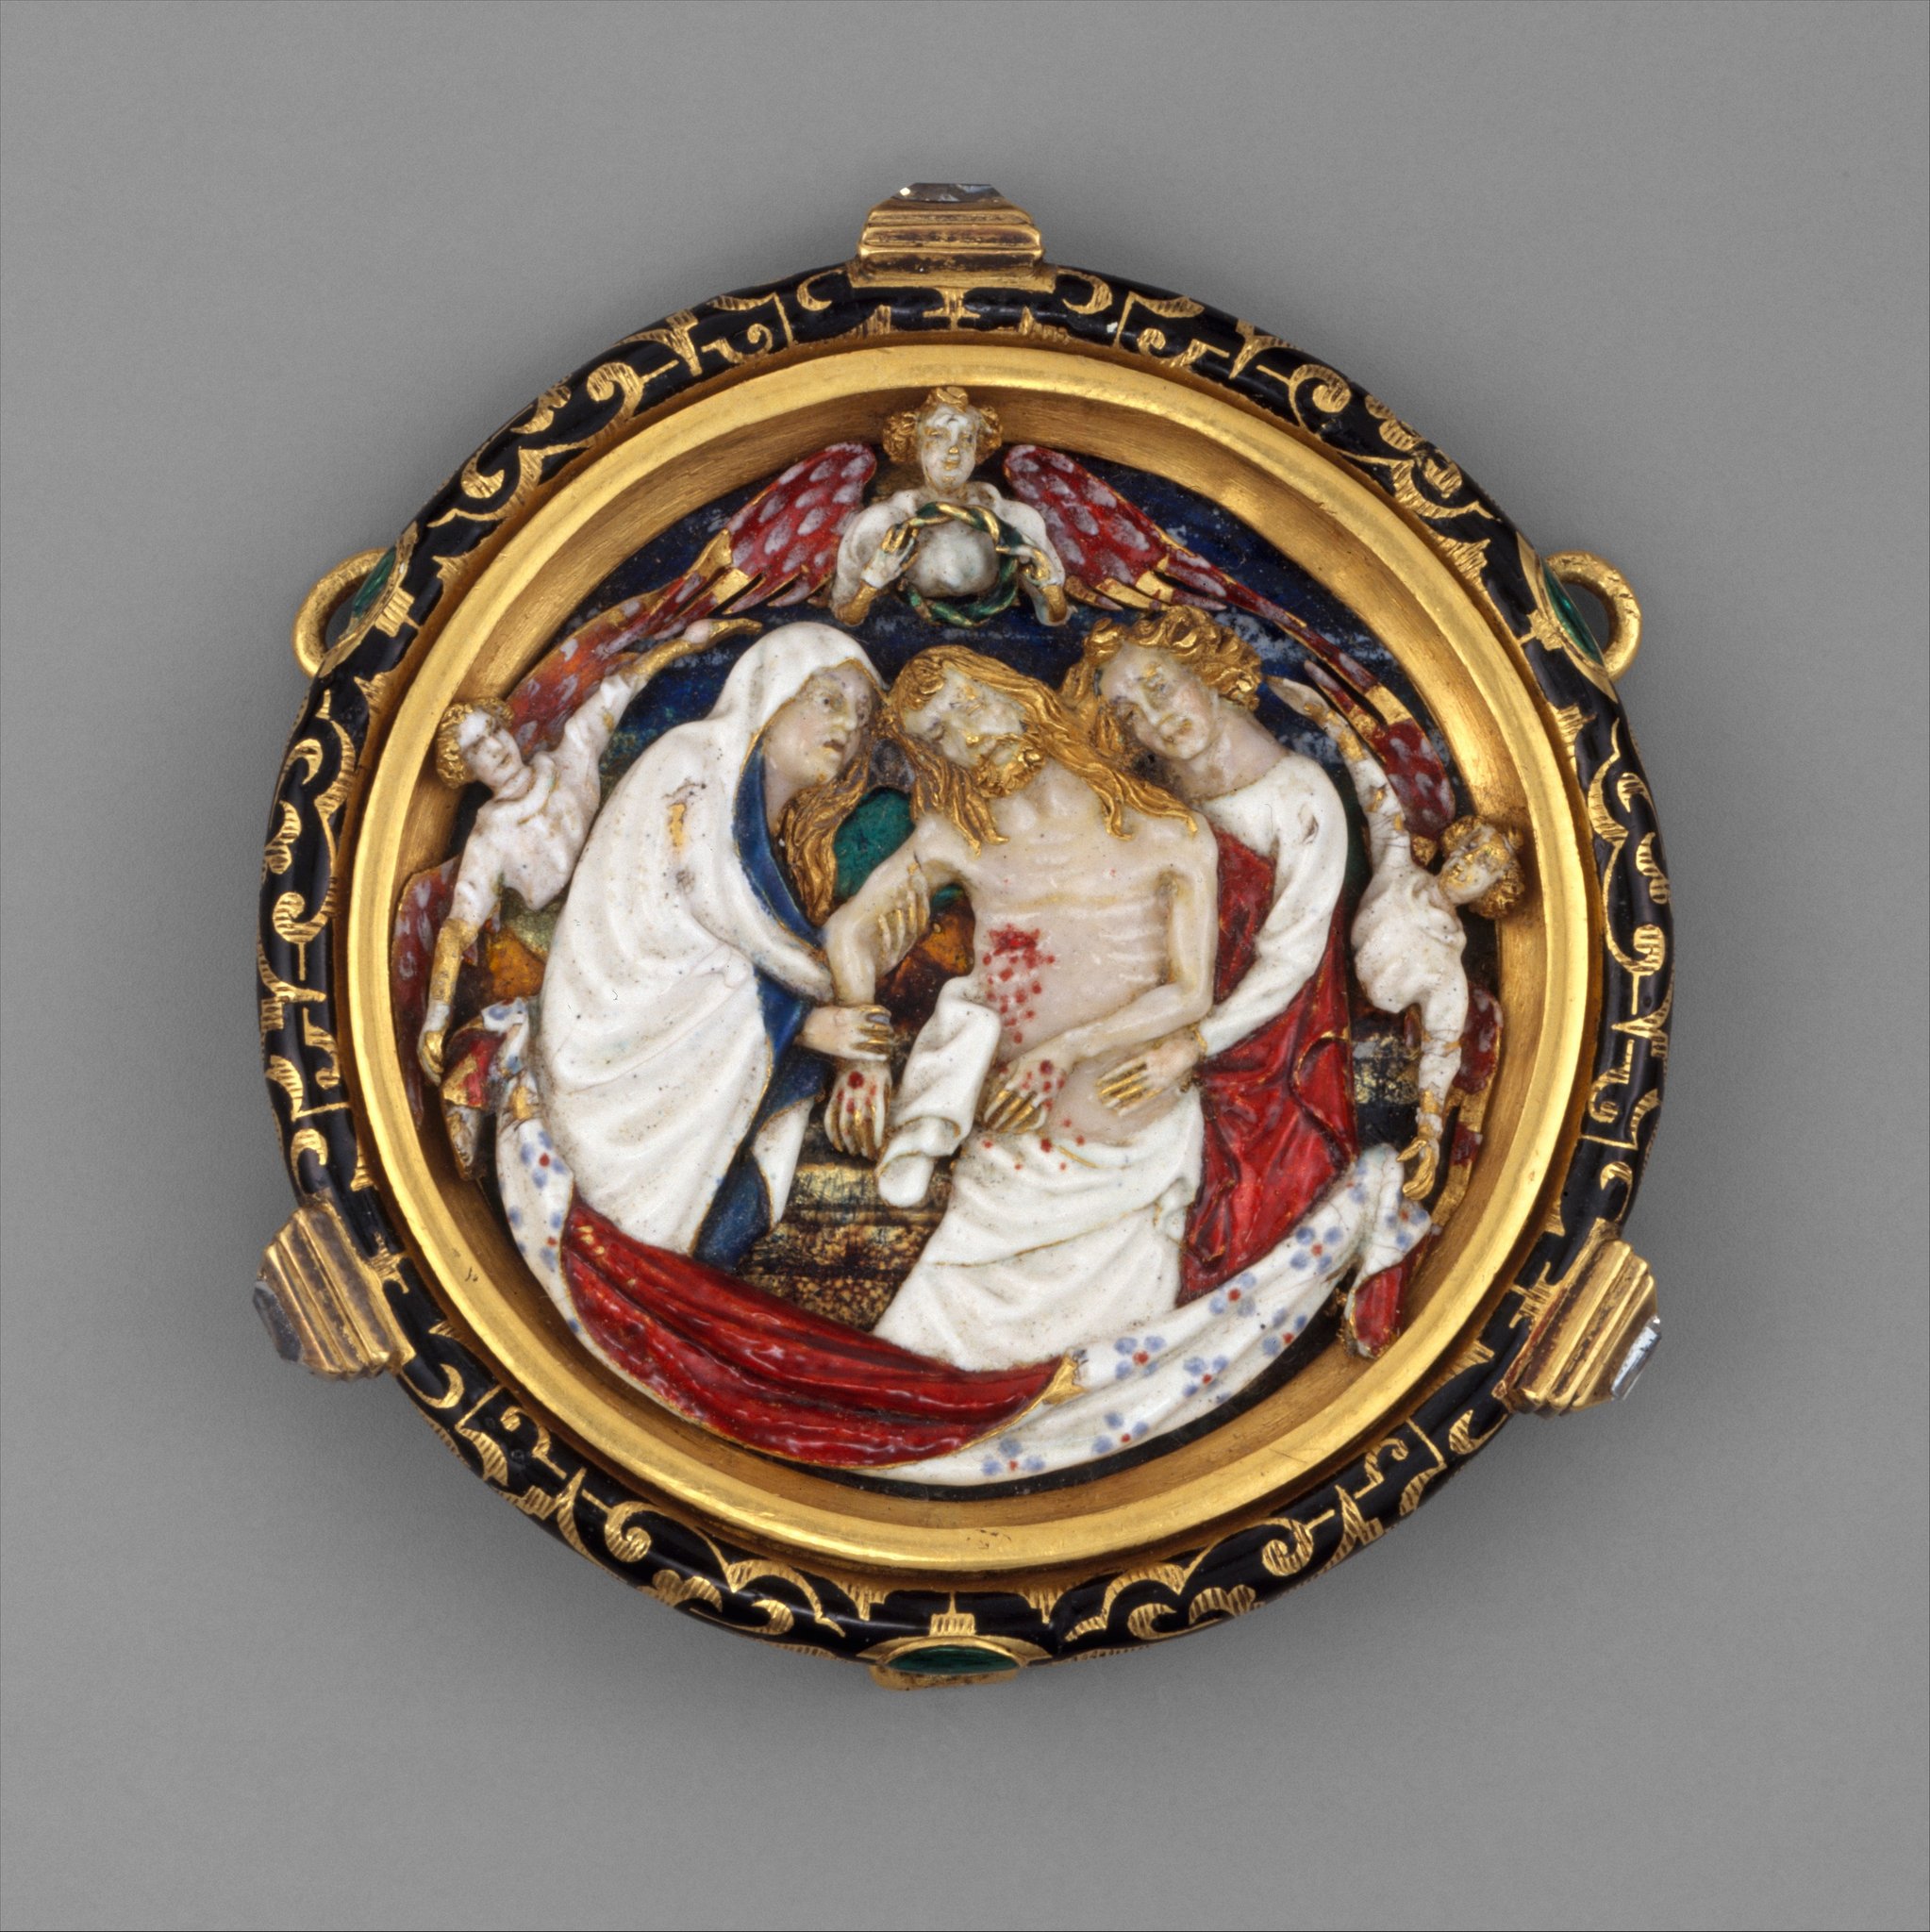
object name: hat ornament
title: The Dead Christ with the Virgin, Saint John, and Angels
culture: french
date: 1390-1405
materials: enamel, gold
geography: france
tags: angels,christ,virgin mary,saint john